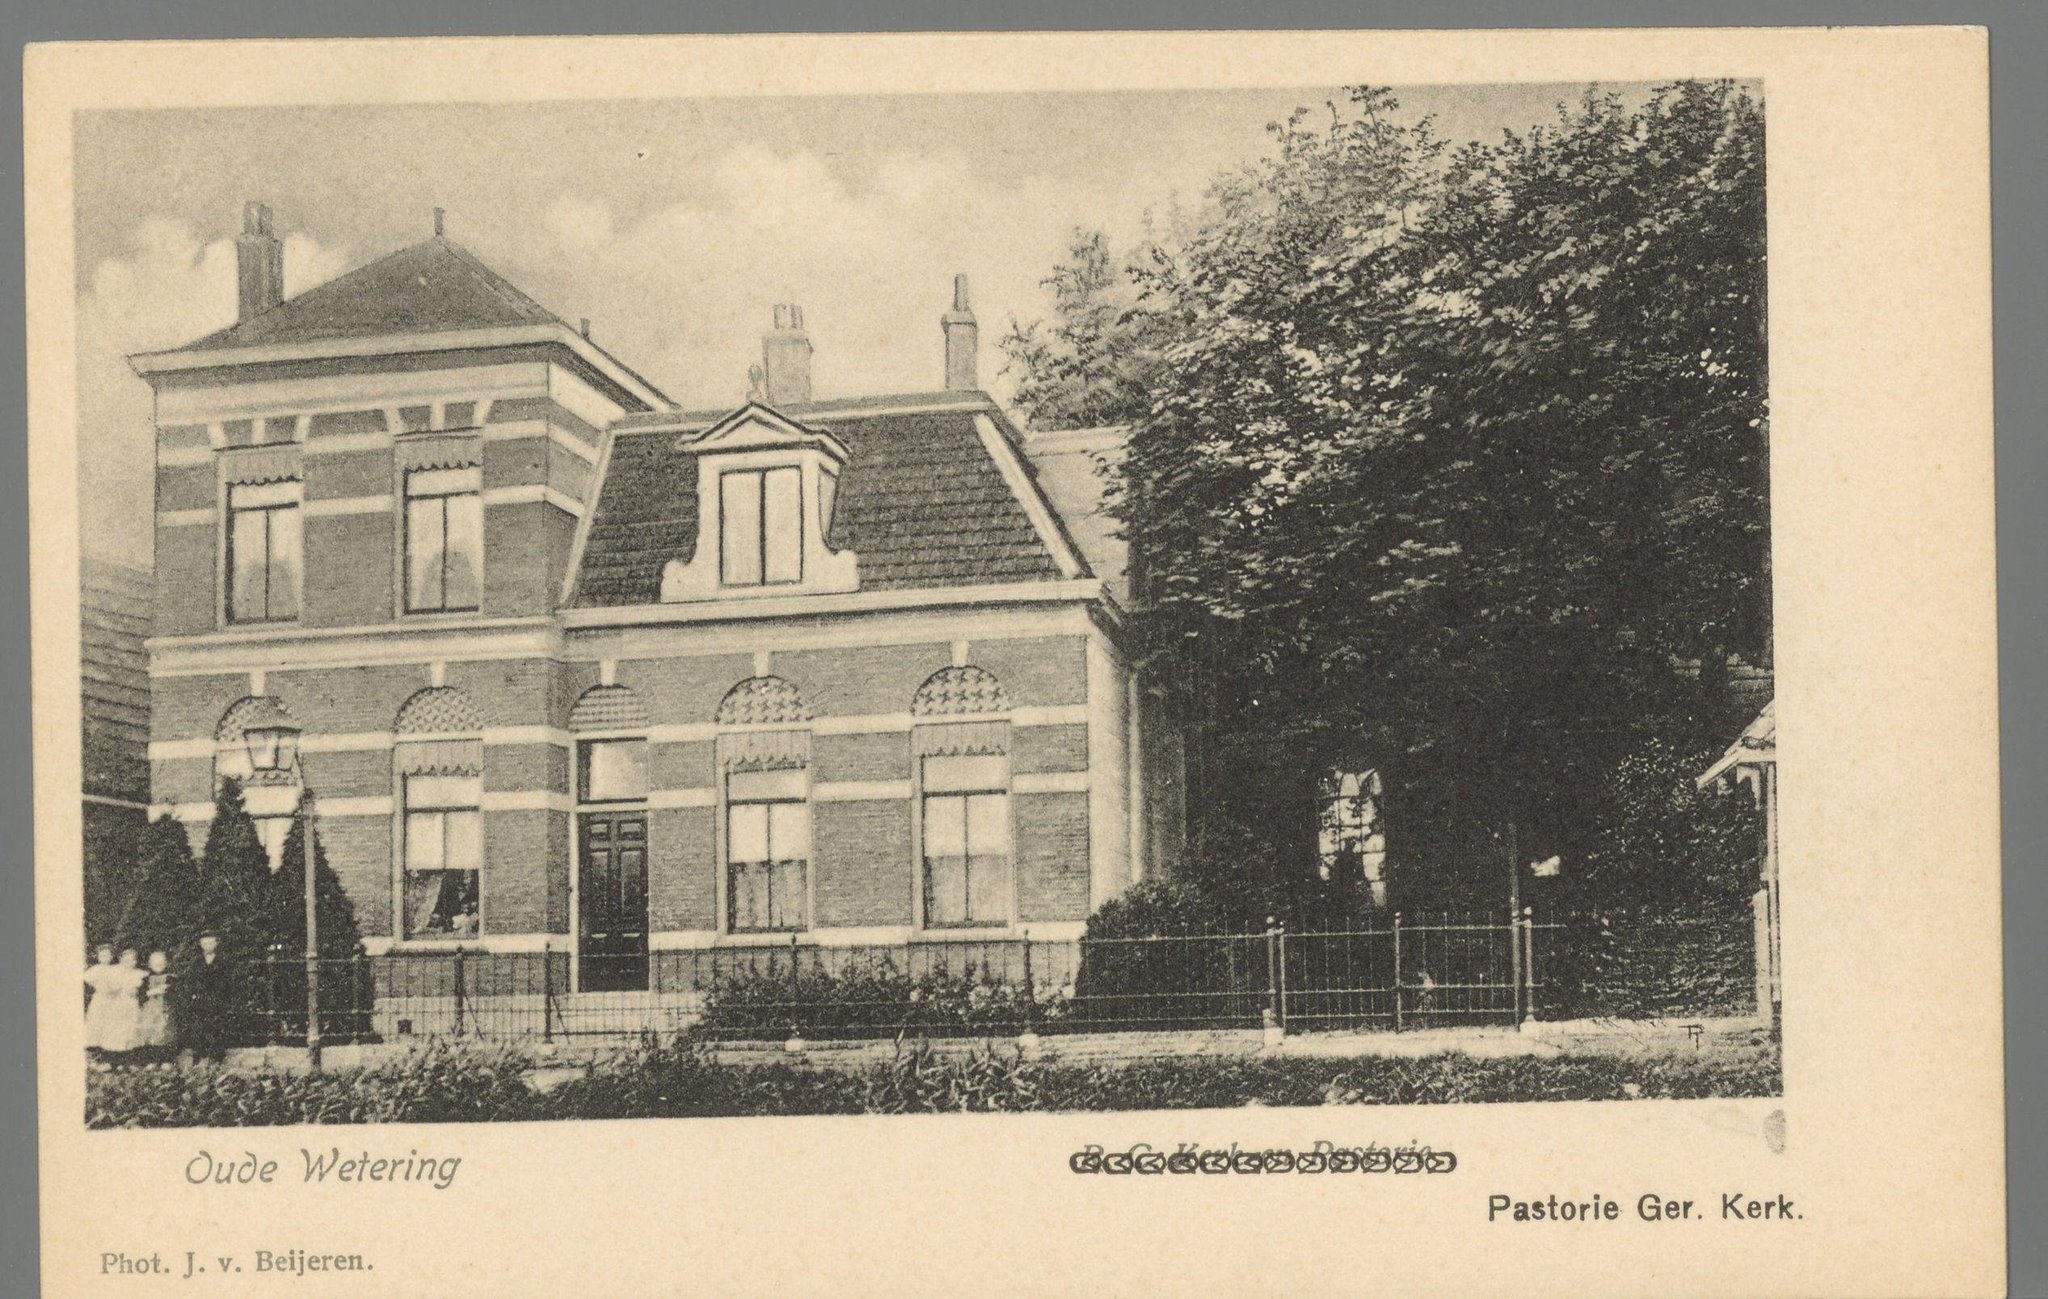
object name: ansichtkaart, prentbriefkaart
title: Oude Wetering. Pastorie Ger. Kerk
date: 1892-1905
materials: cardboard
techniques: photograph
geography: oude wetering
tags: parts of church exterior and annexes - qq - small church, chapel